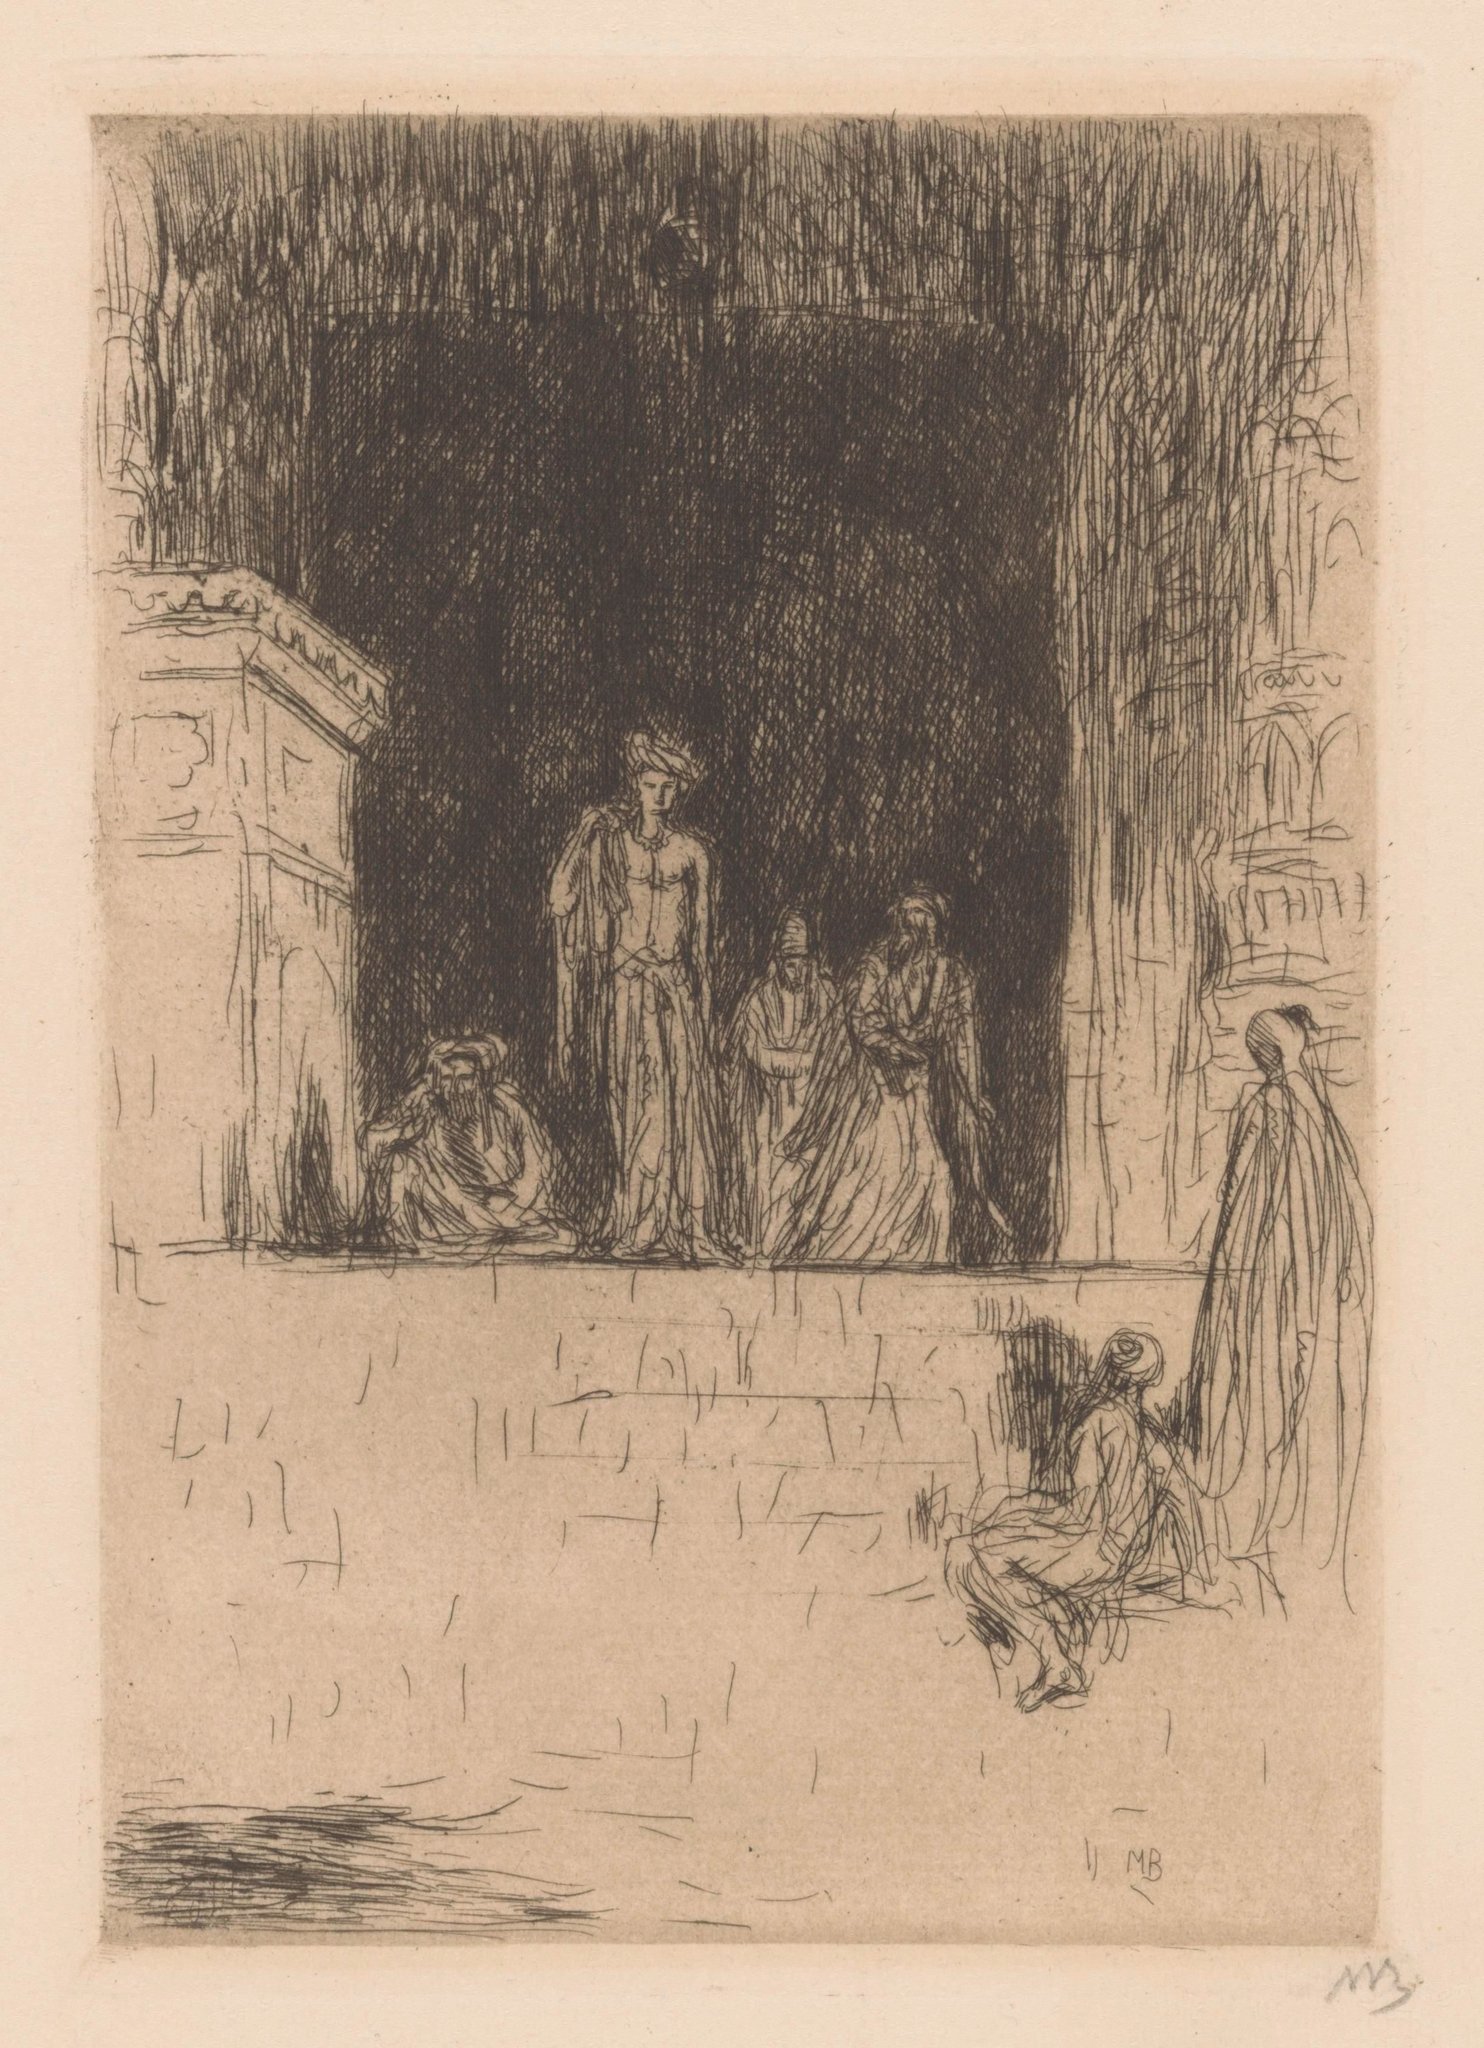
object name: print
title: Ingang van een hindoetempel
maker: marius bauer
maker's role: draughtsman, print maker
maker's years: 1867-1932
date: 1899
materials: paper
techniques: etching, intaglio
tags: temple, shrine ~ hinduism, buddhism, jainism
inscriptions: collector's mark: Lugt 2228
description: Verschillende figuren op en bij een trap richting de ingang van een hindoetempel.